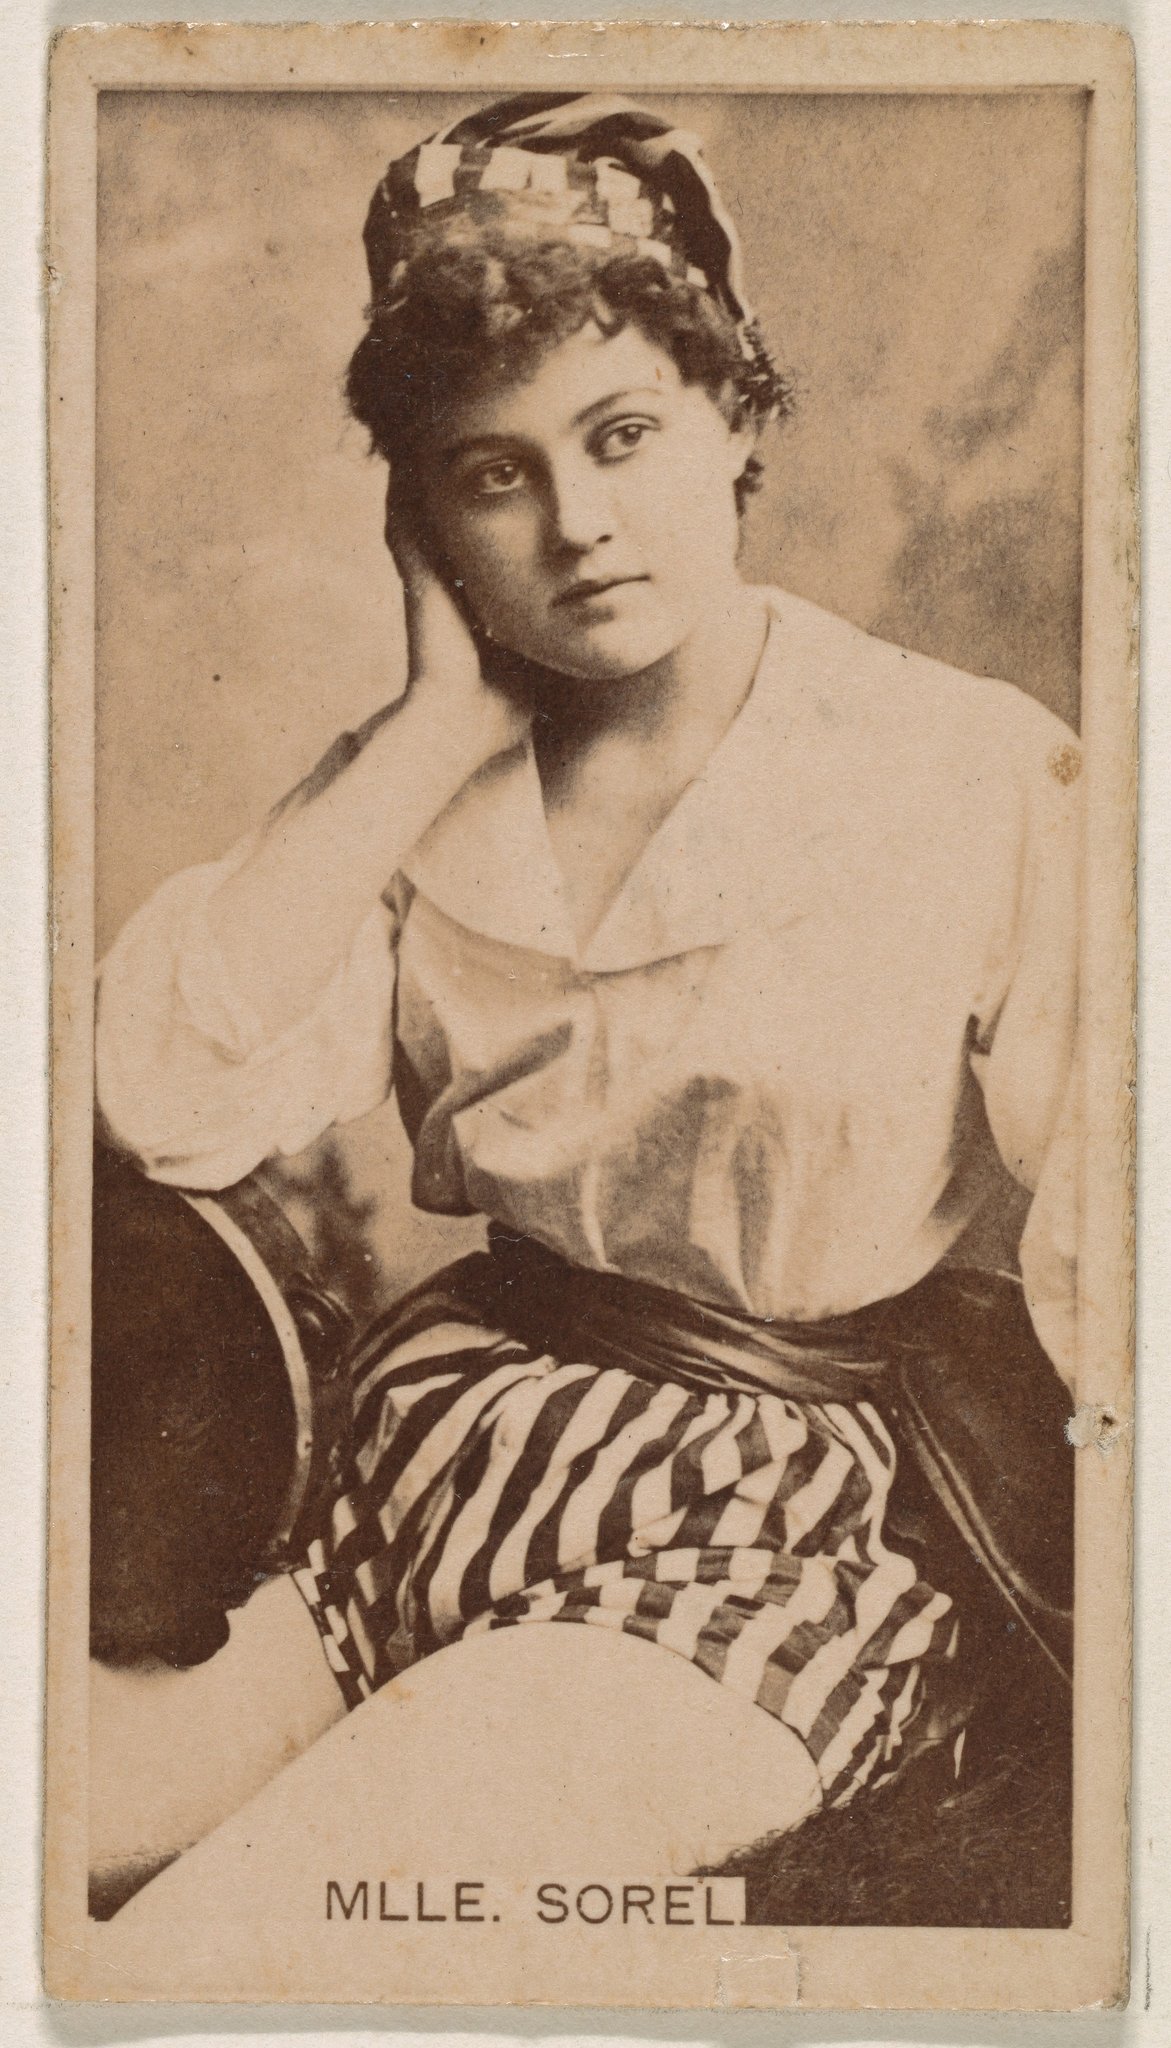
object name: photograph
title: Mlle. Sorel, from the Actresses series (N245) issued by Kinney Brothers to promote Sweet Caporal Cigarettes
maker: kinney brothers tobacco company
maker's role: publisher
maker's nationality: american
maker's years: 1869-2011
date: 1890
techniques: albumen silver print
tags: portraits,women,actresses